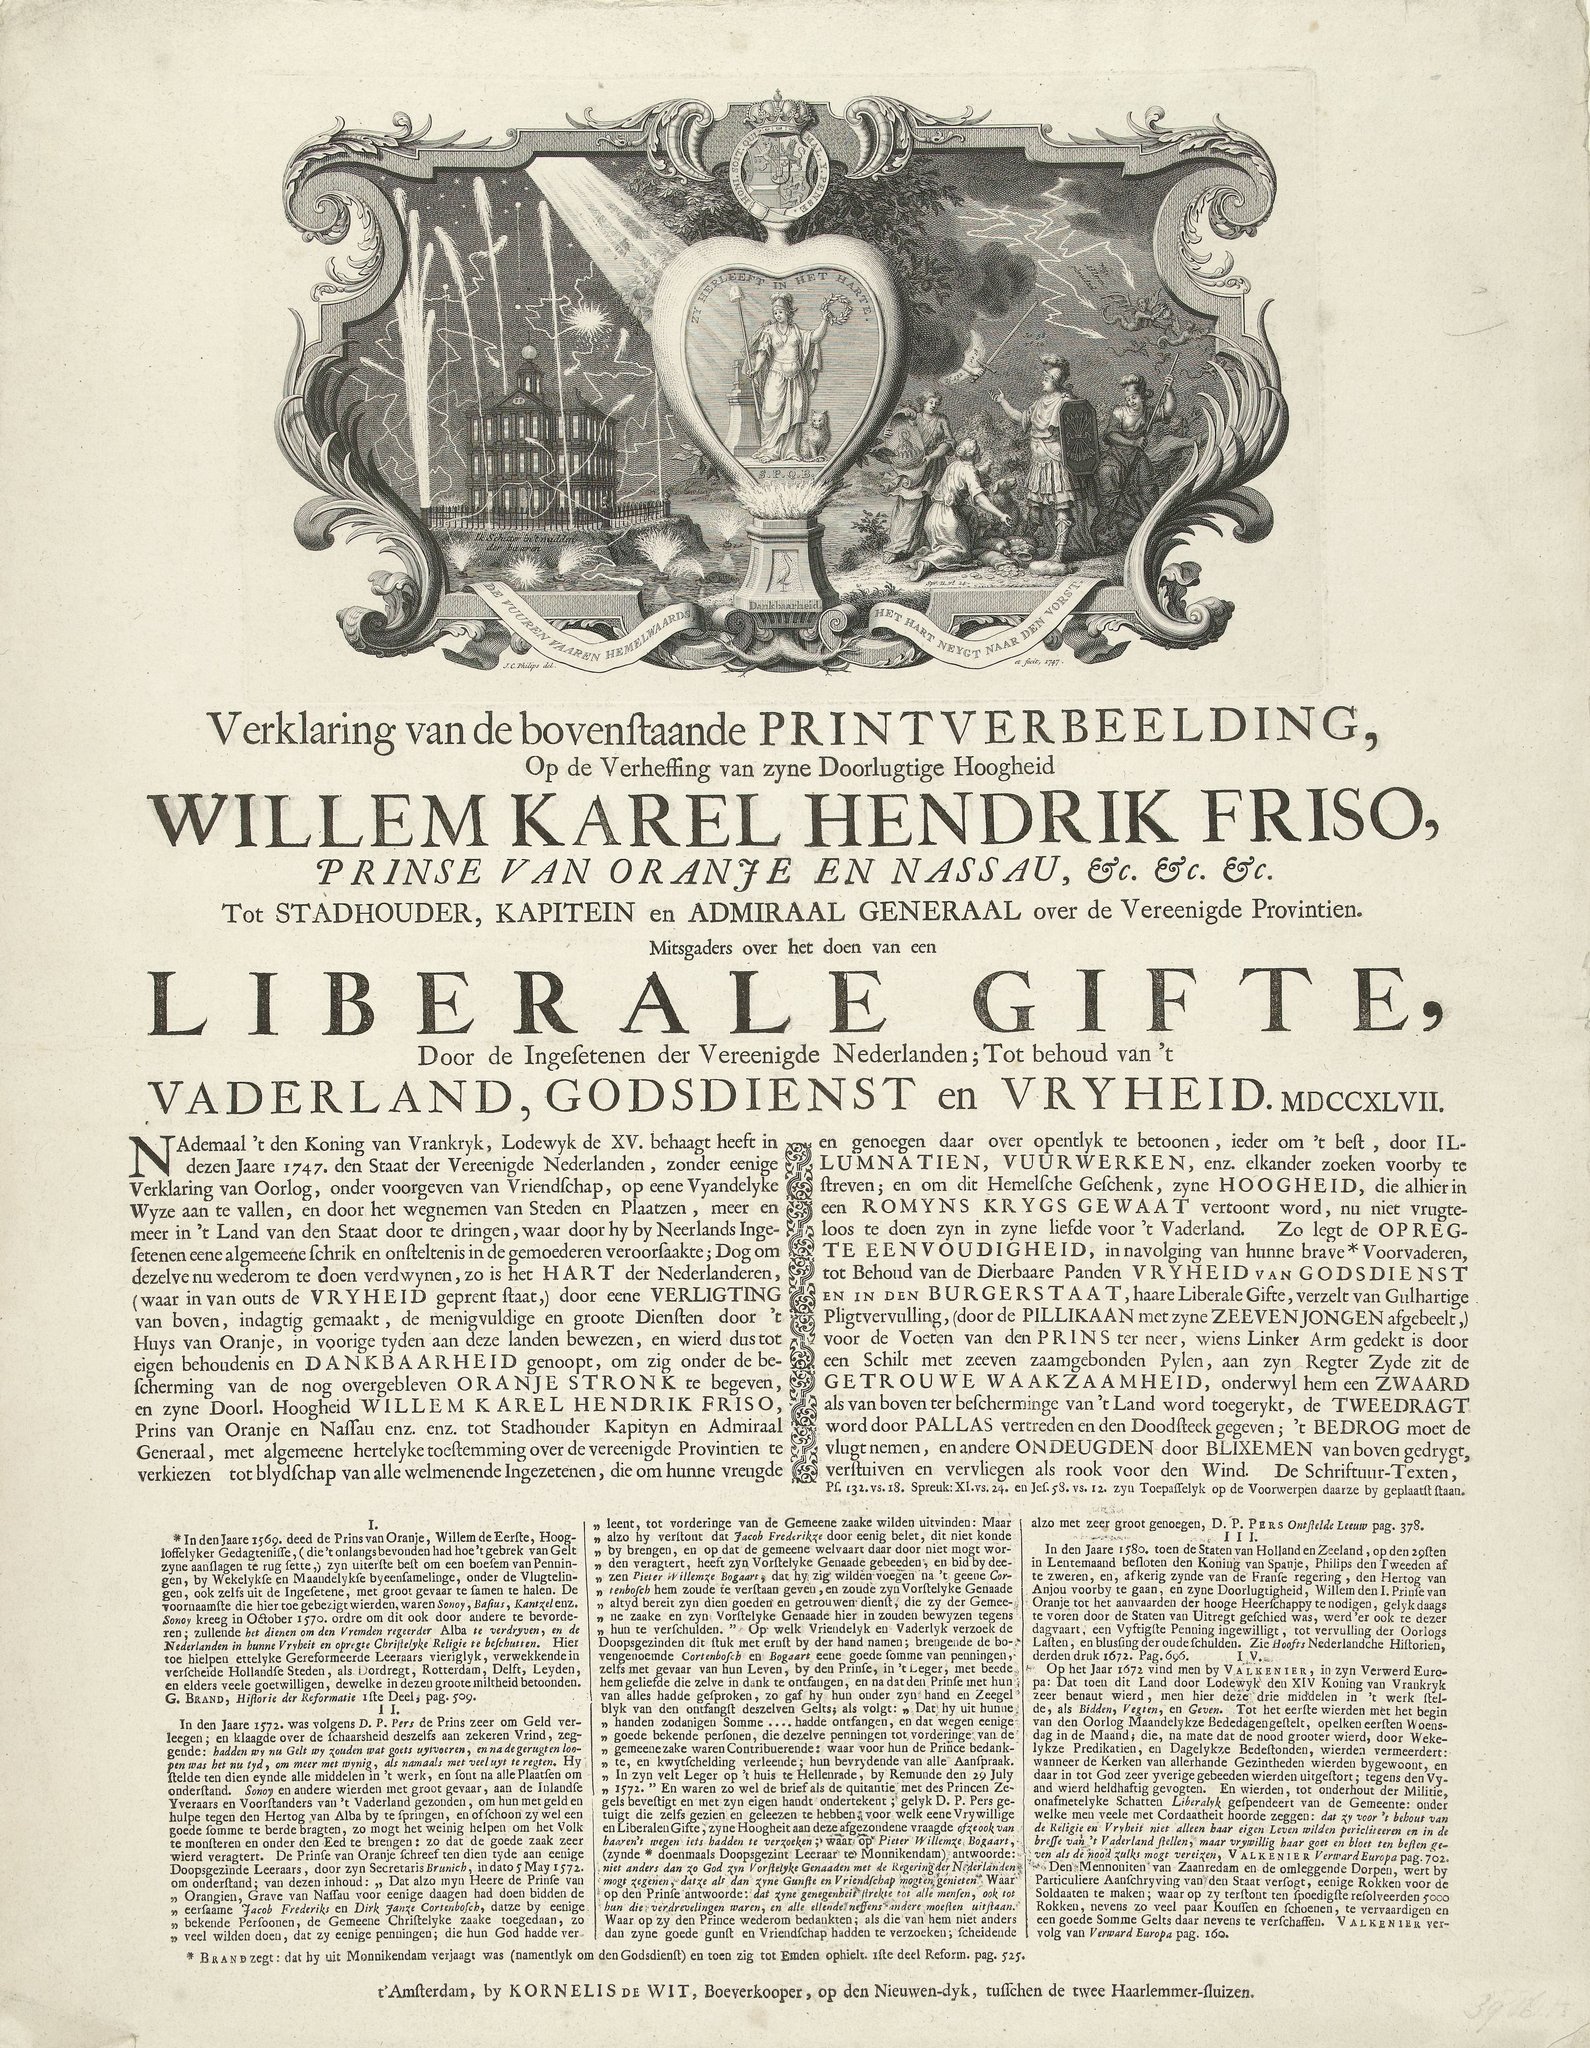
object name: print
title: De vuuren vaaren hemelwaarts / Het hart neygt naar den vorst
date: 1747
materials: paper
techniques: engraving, etching, letterpress printing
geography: amsterdam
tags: the hague, willem iv (prins van oranje-nassau), bonfire, fire-works (+ illumination, fire-works ~ festive activities)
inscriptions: collector's mark: Lugt 2228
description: Allegorie op de verheffing van Willem IV tot stadhouder en op de Liberale Gifte van de vijftigste penning gevraagd in 1747 tot steun van het in oorlog verkerende land. Bovenaan een allegorische voorstelling met centraal de Vrijheid, links vuurwerk, rechts aanvaardt de prins het zwaard van Goddelijk Bestuur. Op het blad onder de plaat een uitleg van de voorstelling in twee kolommen en een historisch relaas over eerdere penningen en giften in het verleden in drie kolommen.